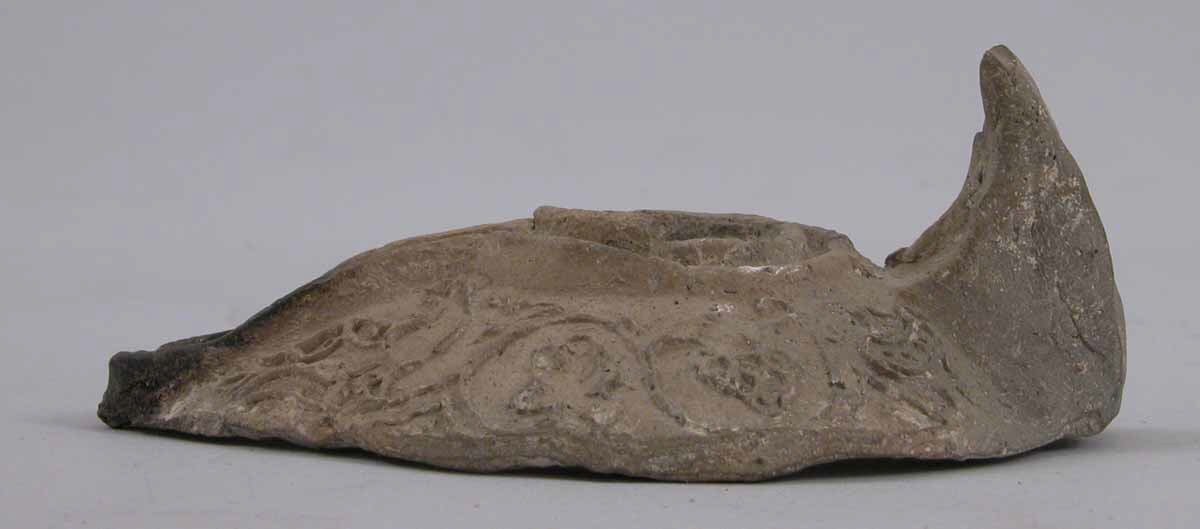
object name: lamp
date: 601-800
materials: earthenware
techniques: molding